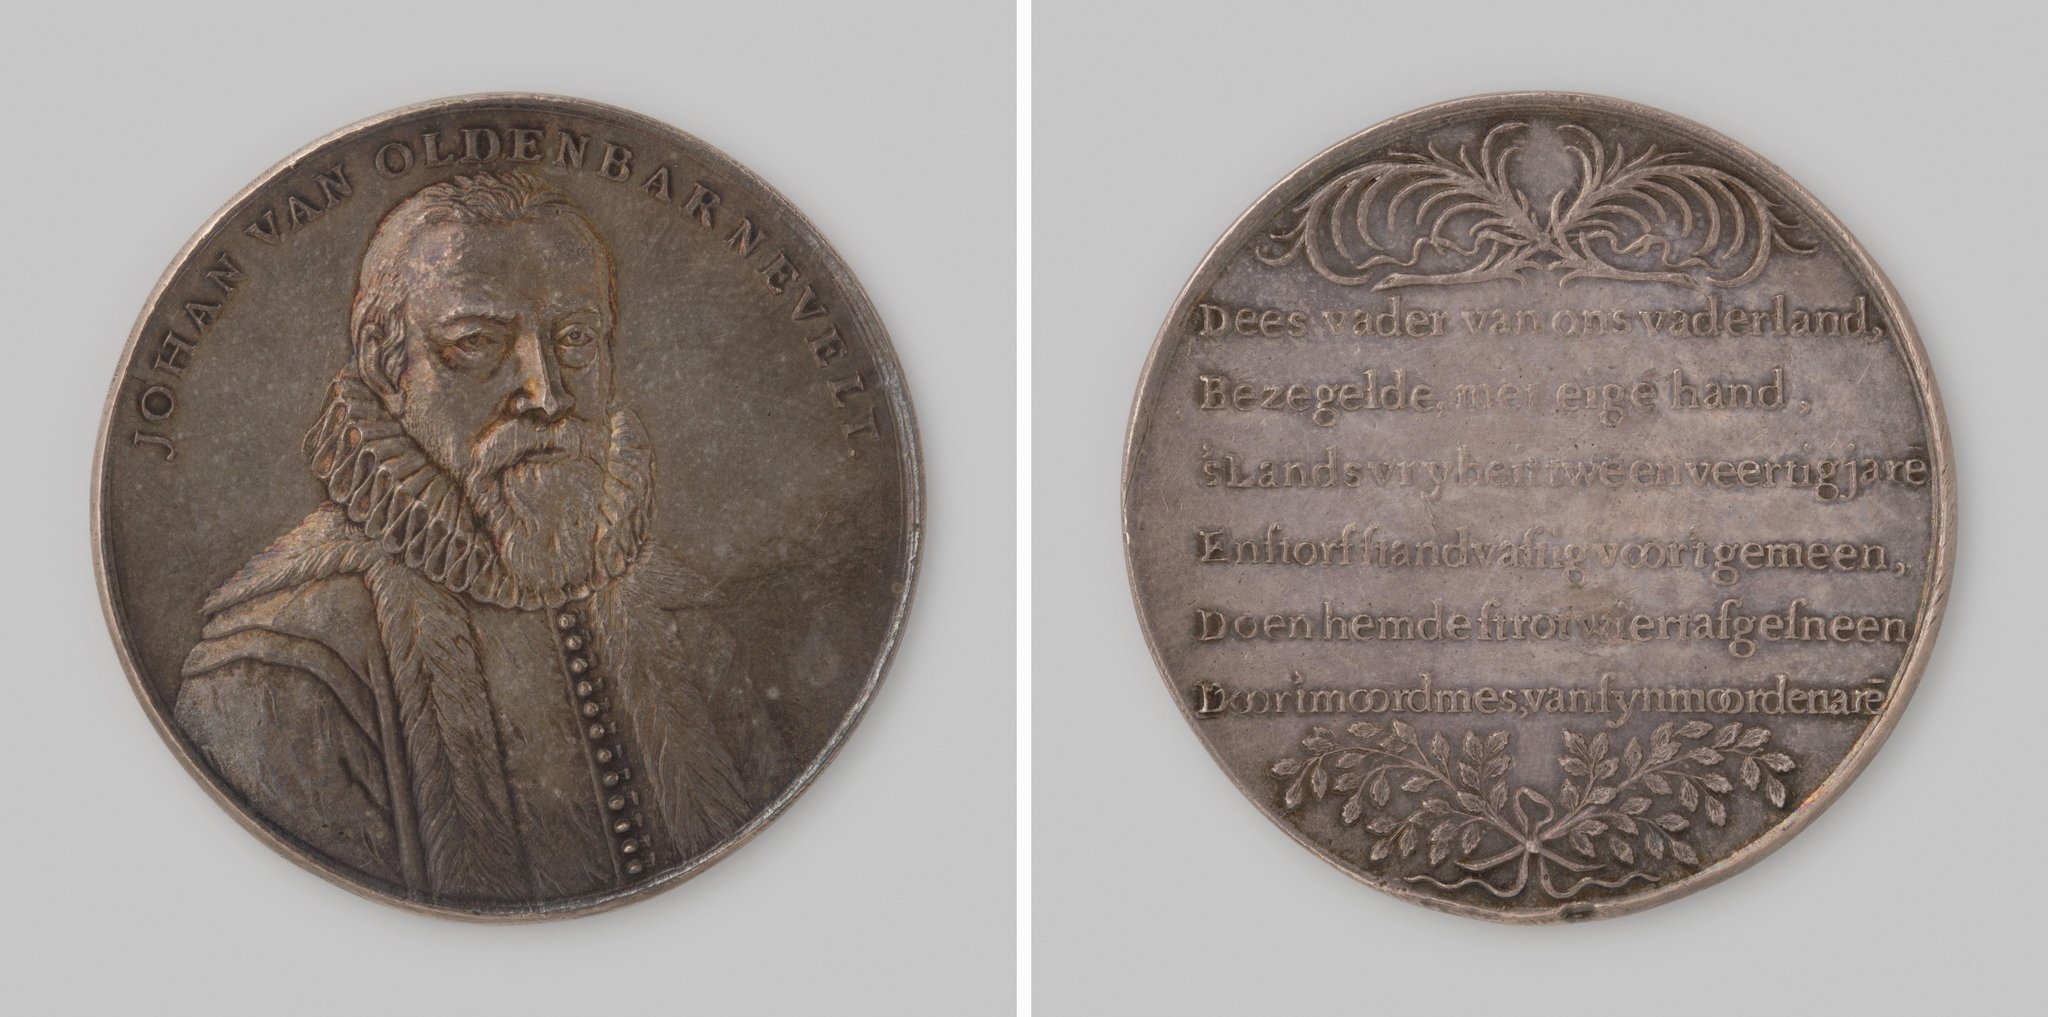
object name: history medal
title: Onthoofding van Johan van Oldenbarnevelt 1619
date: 1619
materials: silver